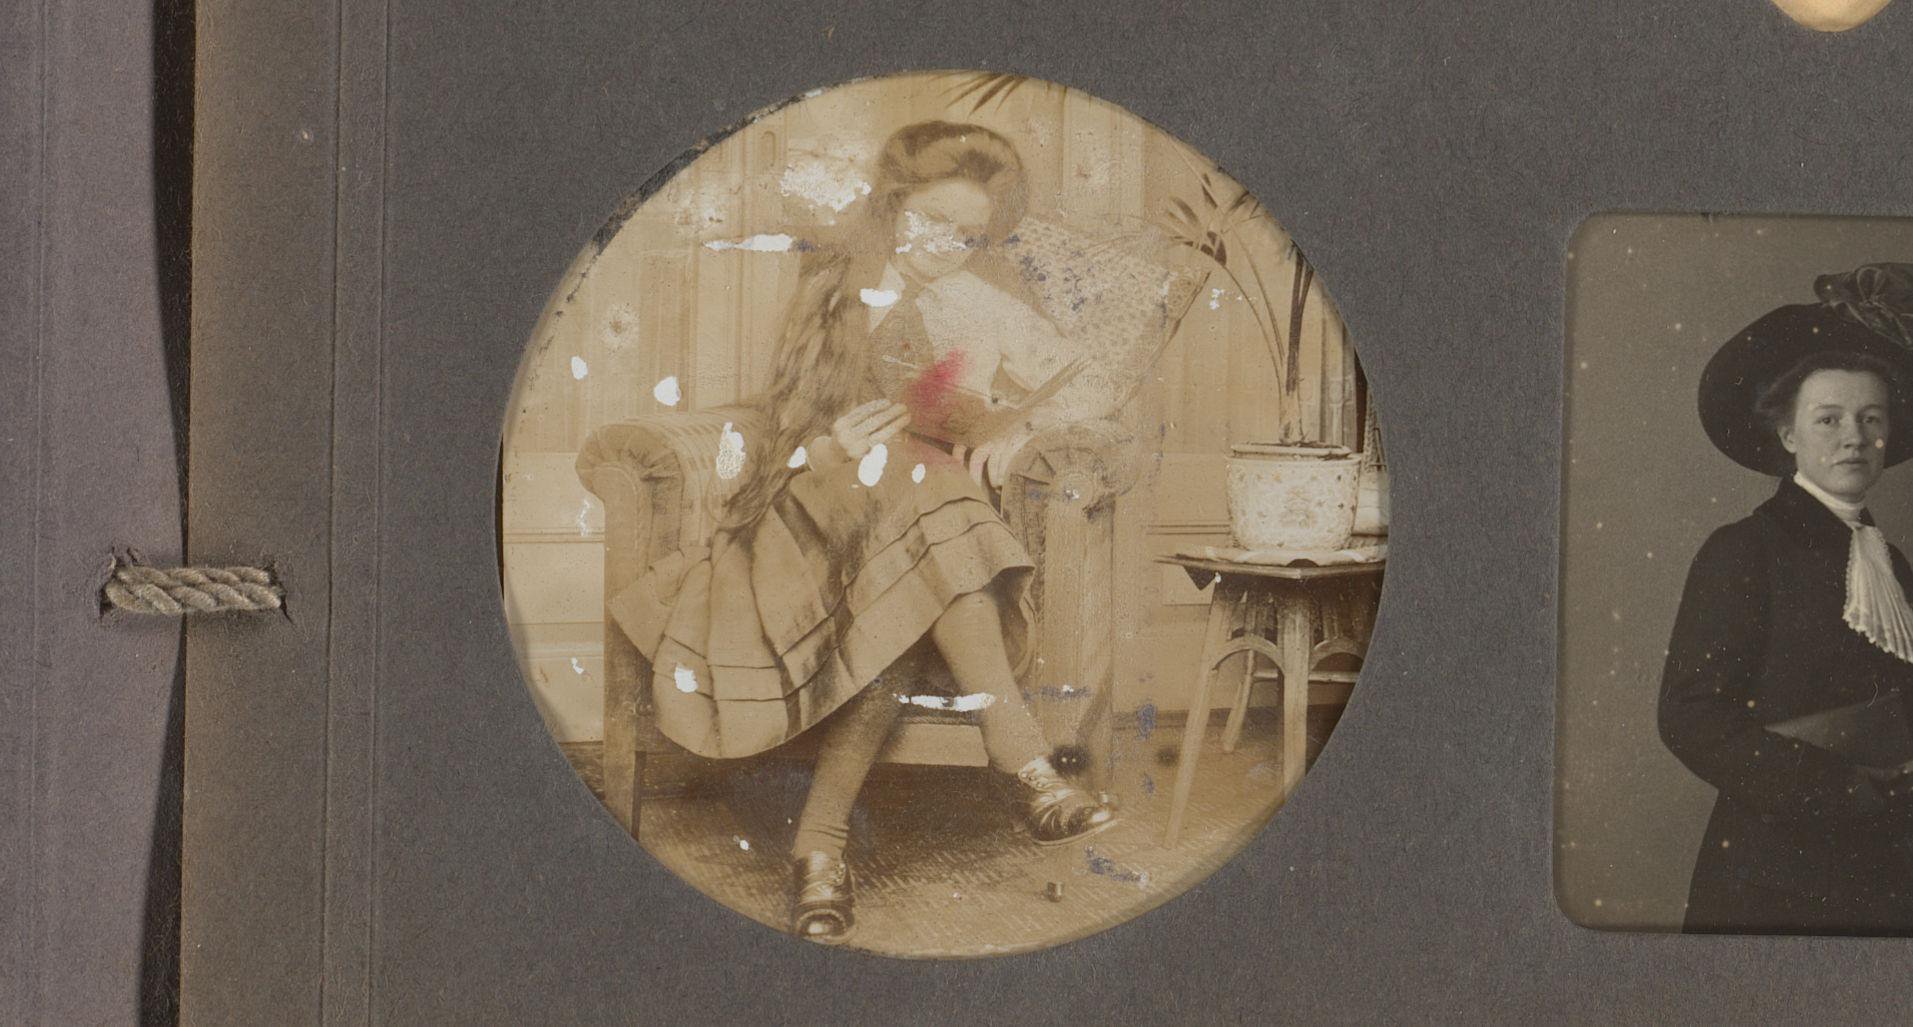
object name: album leaf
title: Portret van Wiesje Merkus met boek in een fauteuil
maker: Anonymous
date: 1908-1912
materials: paper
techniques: gelatin silver print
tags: wiesje merkus, adolescent, young woman, maiden, historical persons